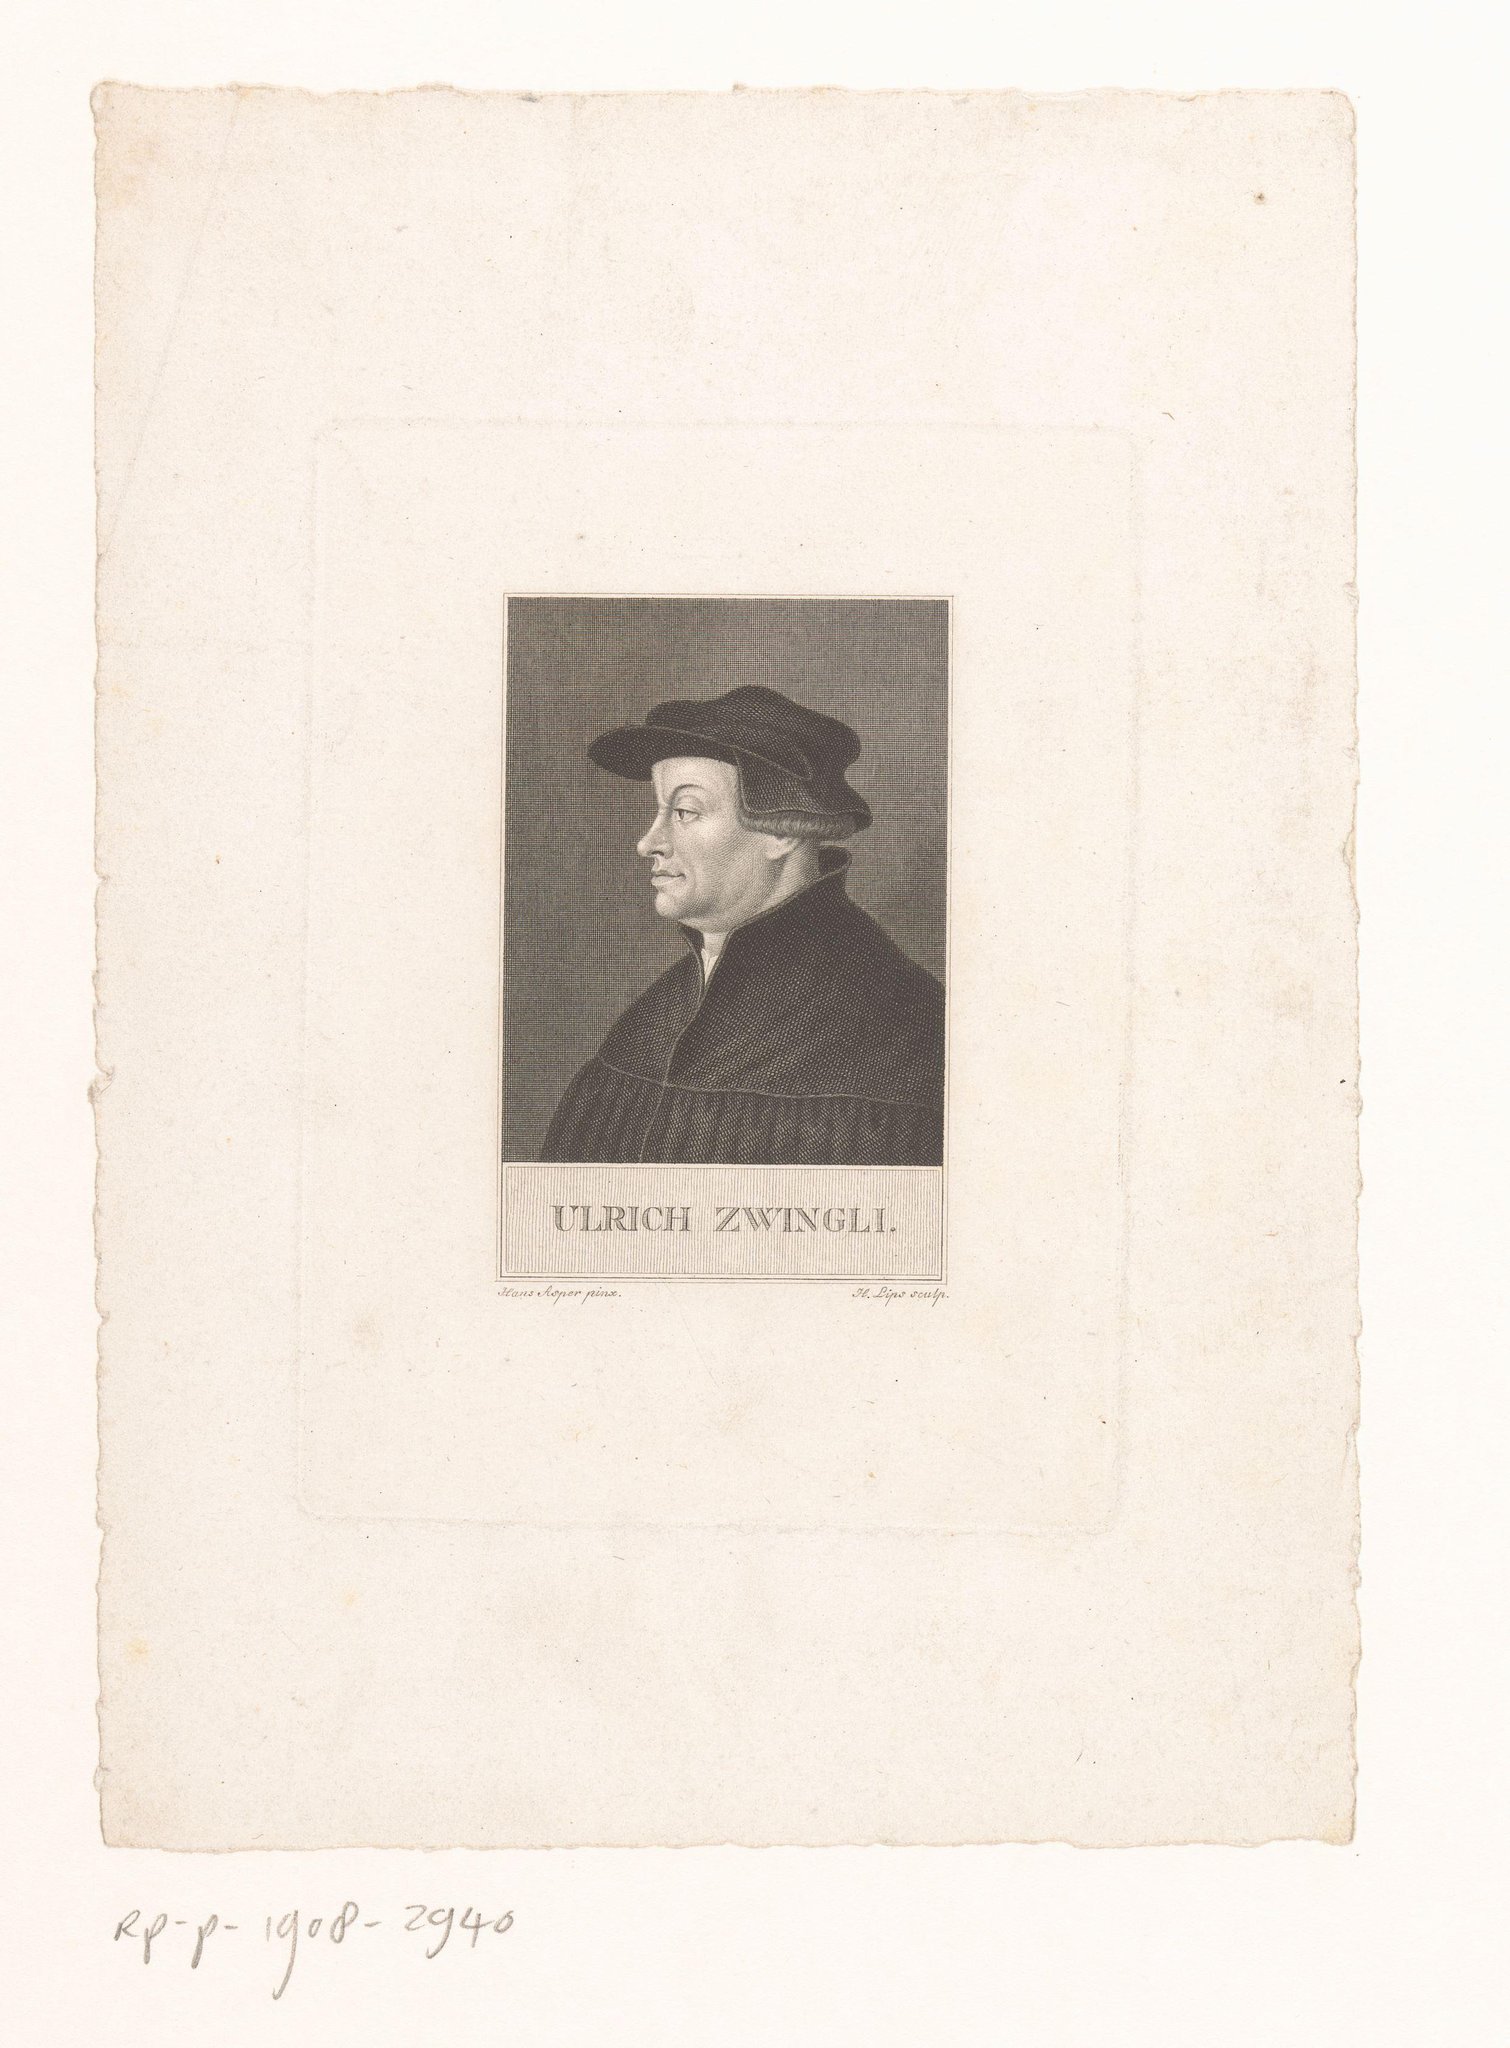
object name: print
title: Portret van Ulrich Zwingli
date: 1768-1817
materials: paper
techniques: engraving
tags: clergyman, theologian, historical persons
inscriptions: collector's mark: Lugt 2228